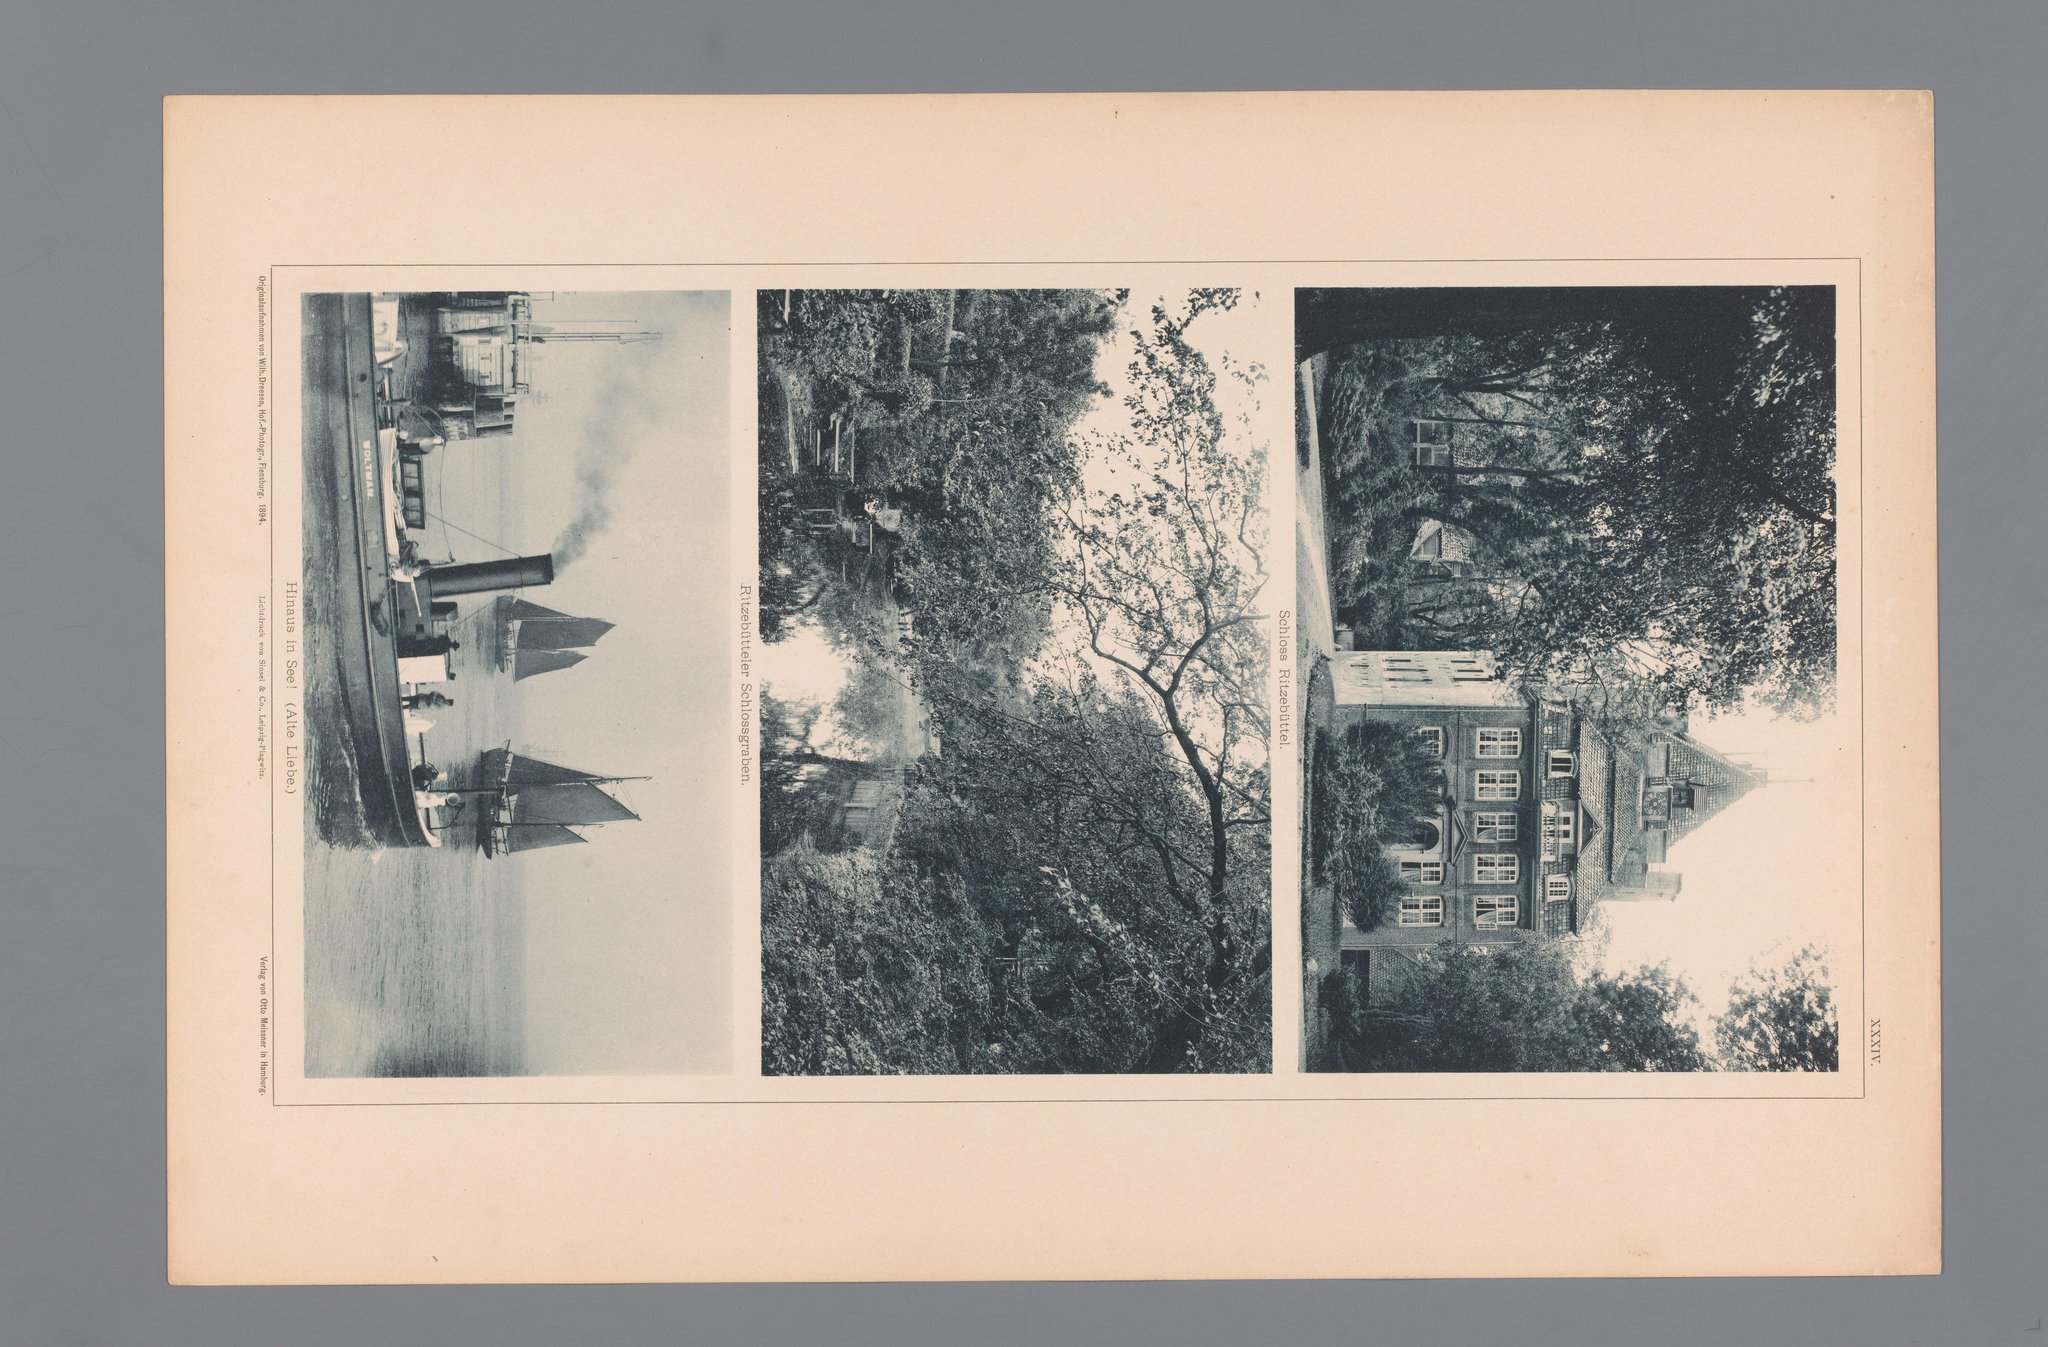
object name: photomechanical print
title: Drie afbeeldingen van een gezicht op Schloss Ritzebüttel, een gezicht op de slotgracht van Schloss Ritzebüttel en een stoomschip en twee zeilschepen die de haven verlaten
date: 1894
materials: paper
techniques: photograph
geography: elbe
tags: moat ~ fortified city, castle, steamship, motorship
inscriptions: inscription: ‘Originalaufnahmen von Wilh. Dreesen, Hof.-Photogr., Flensburg. 1894.’, number: ‘XXXIV.’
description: Deze prenten maken deel uit van een omslag met 126 prenten op 37 bladen en een tekstblad.